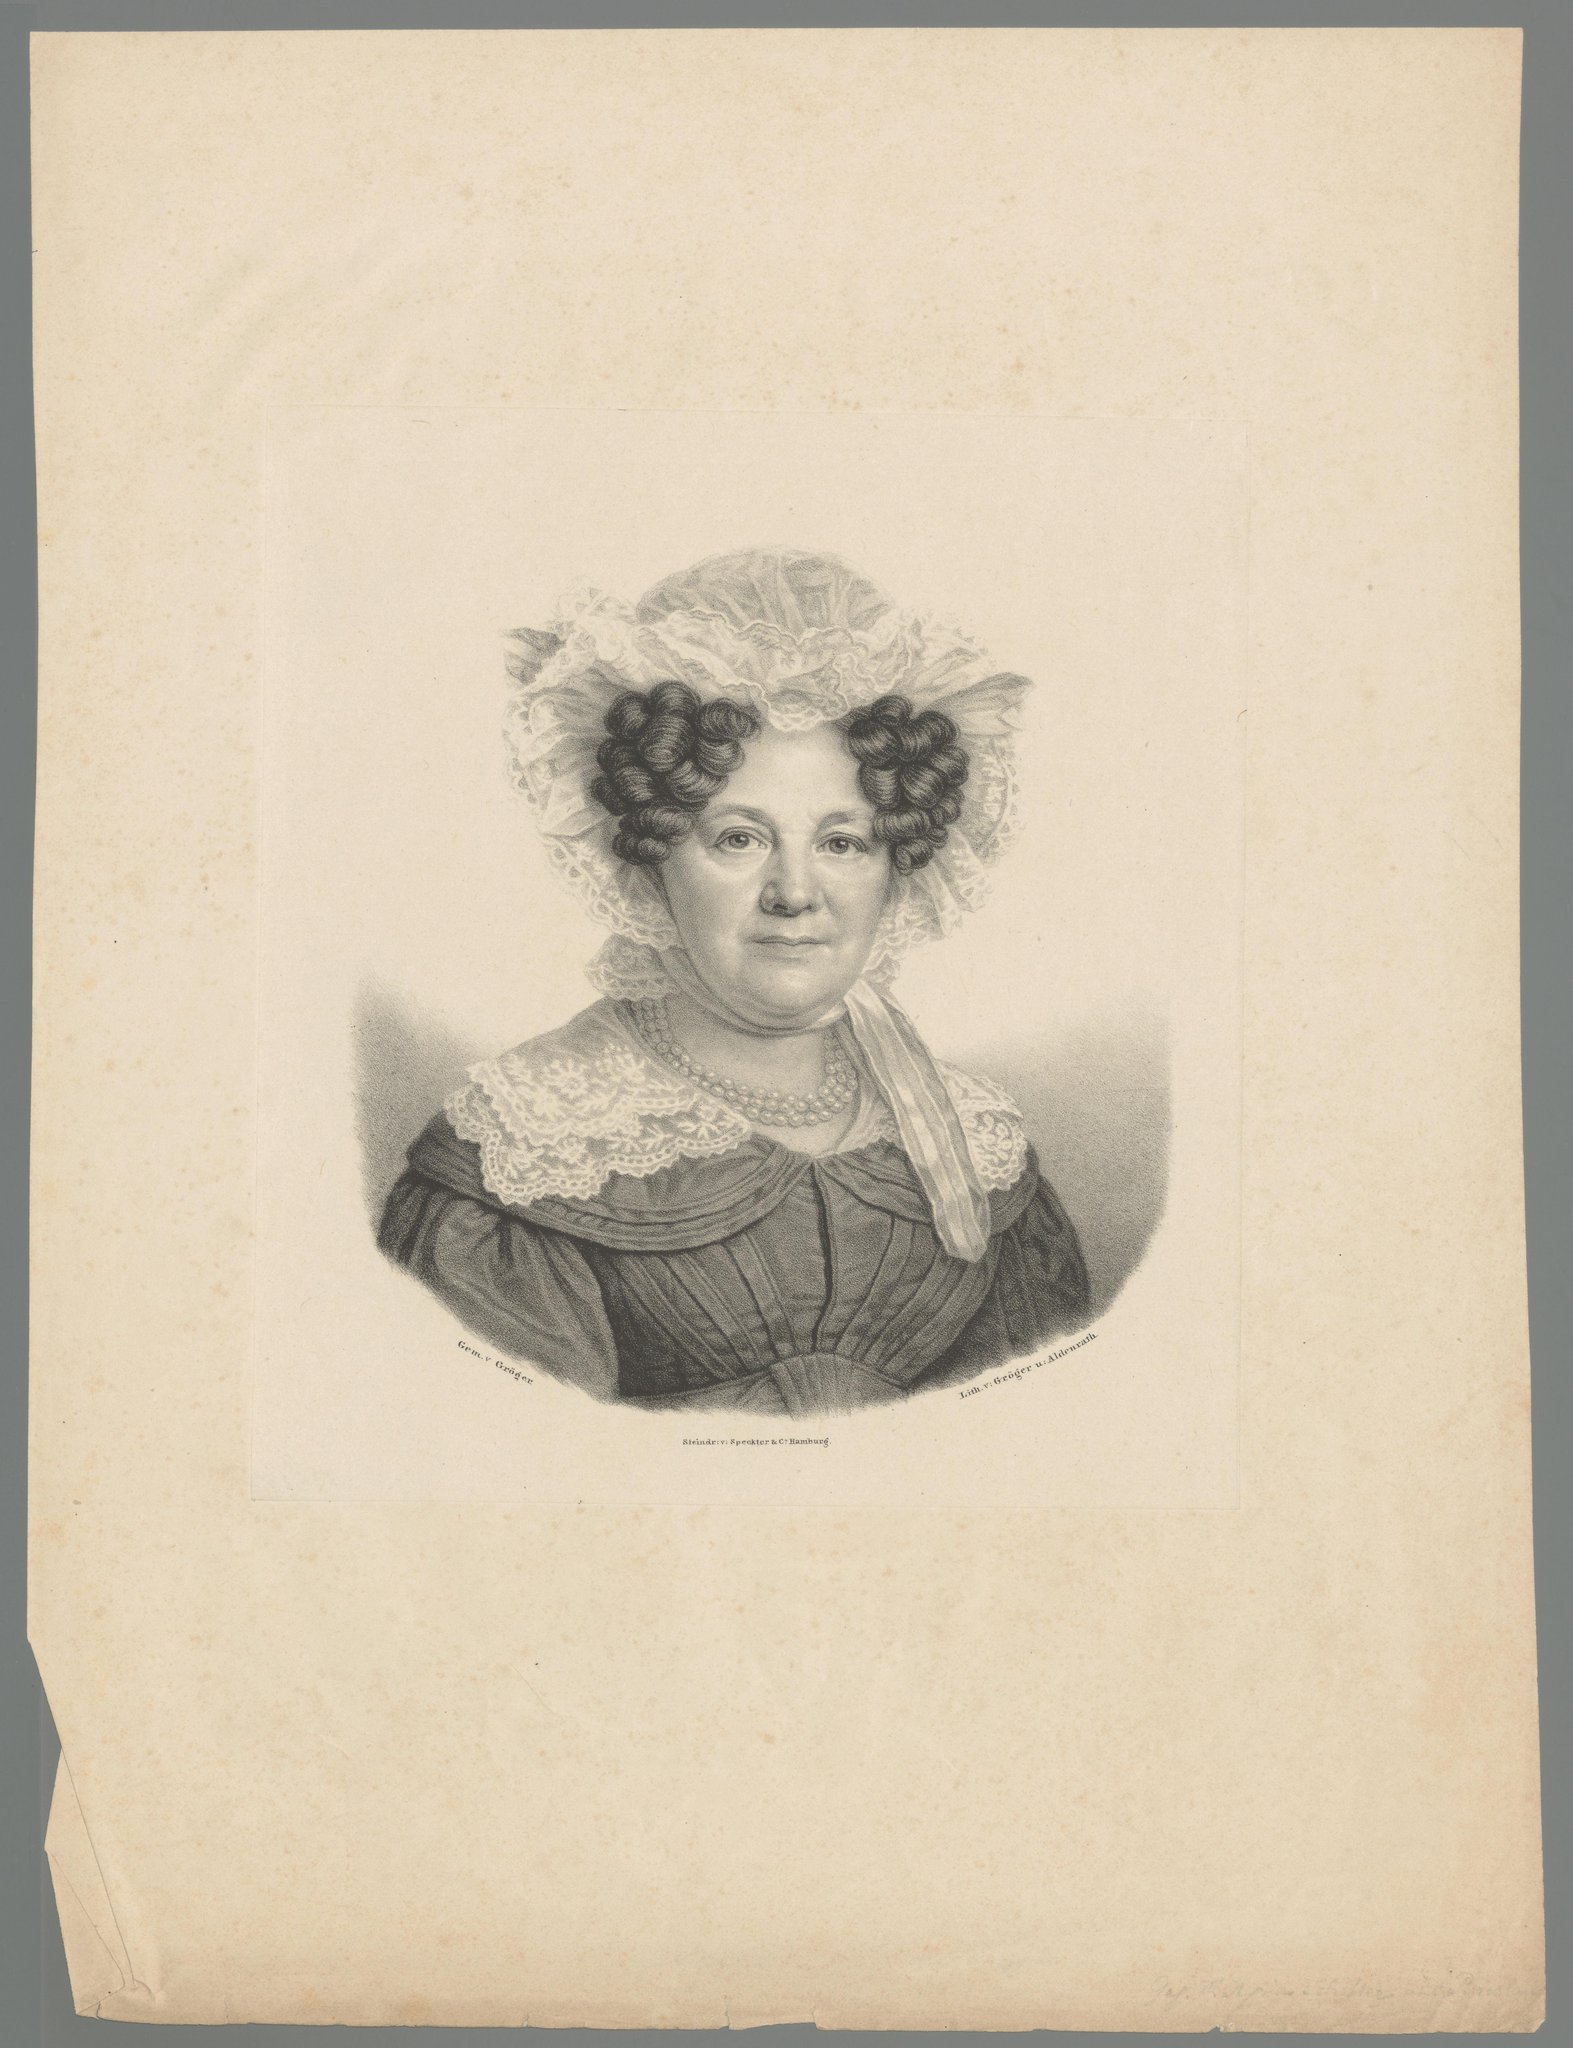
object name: print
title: Portret van een onbekende vrouw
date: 1800-1838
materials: paper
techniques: lithograph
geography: hamburg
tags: adult woman, historical persons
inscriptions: collector's mark: Lugt 2228